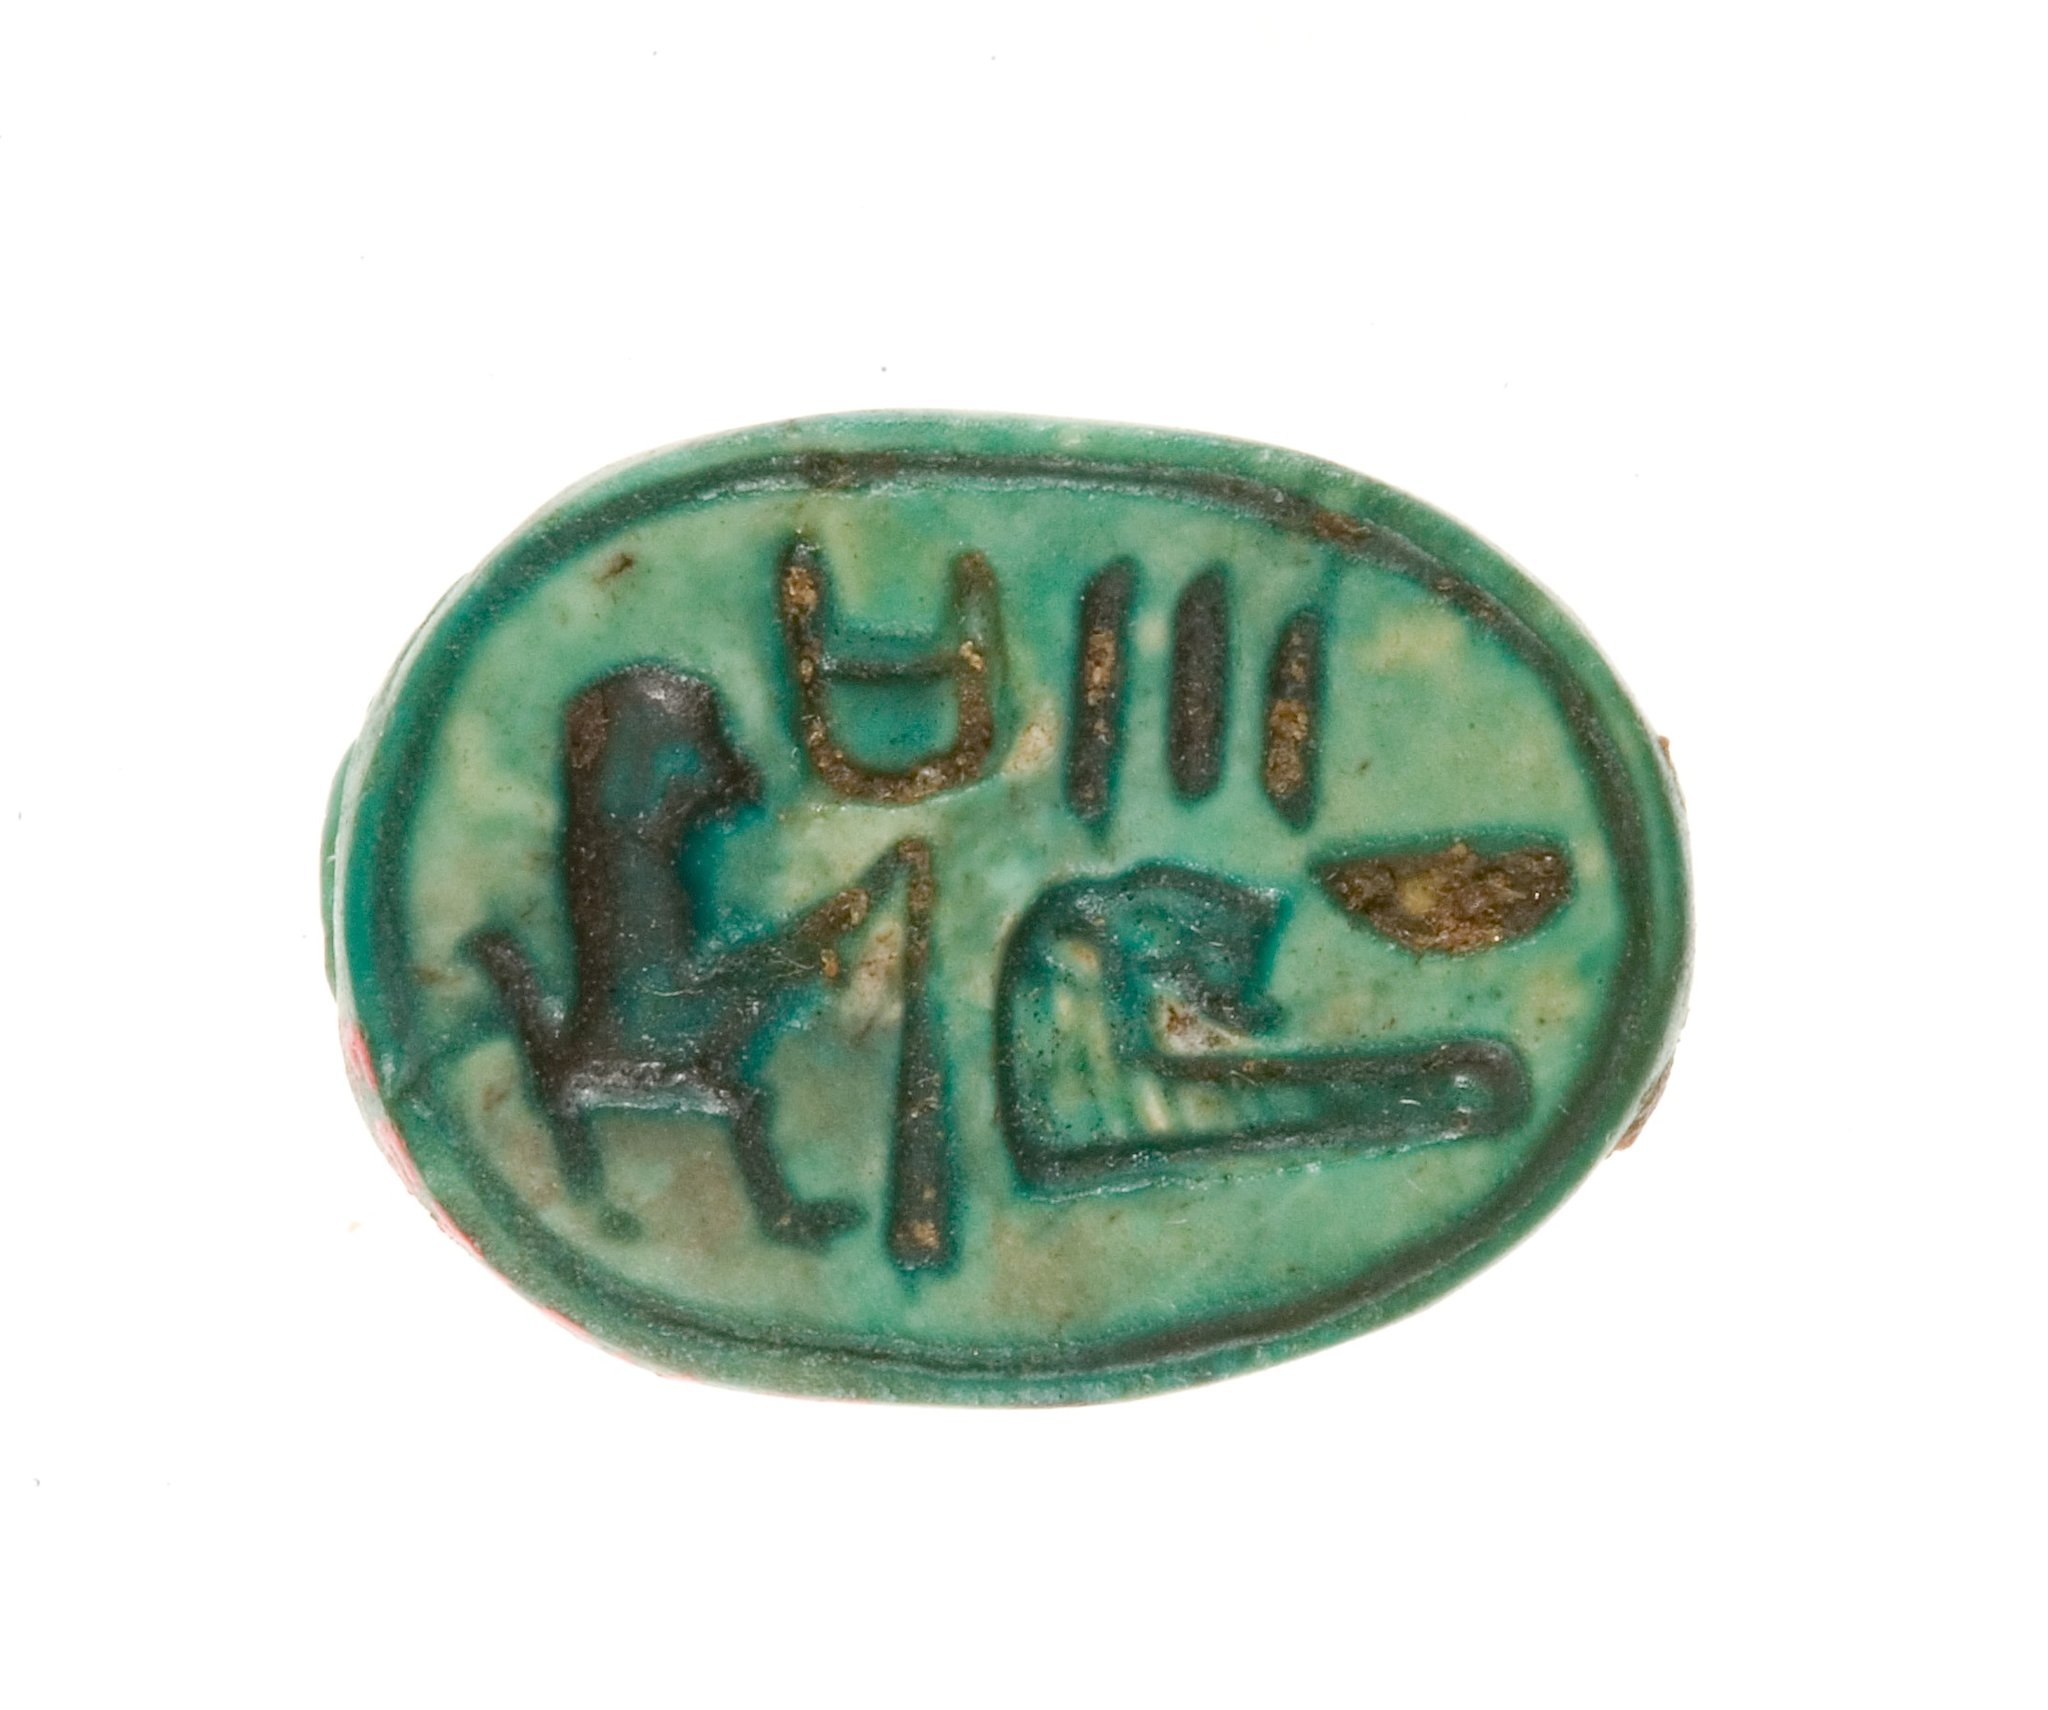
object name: scarab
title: Scarab Inscribed for the [God's] Wife Hatshepsut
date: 1479-1458 BCE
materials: stone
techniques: glazing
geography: egypt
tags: hieroglyphs,scarabs